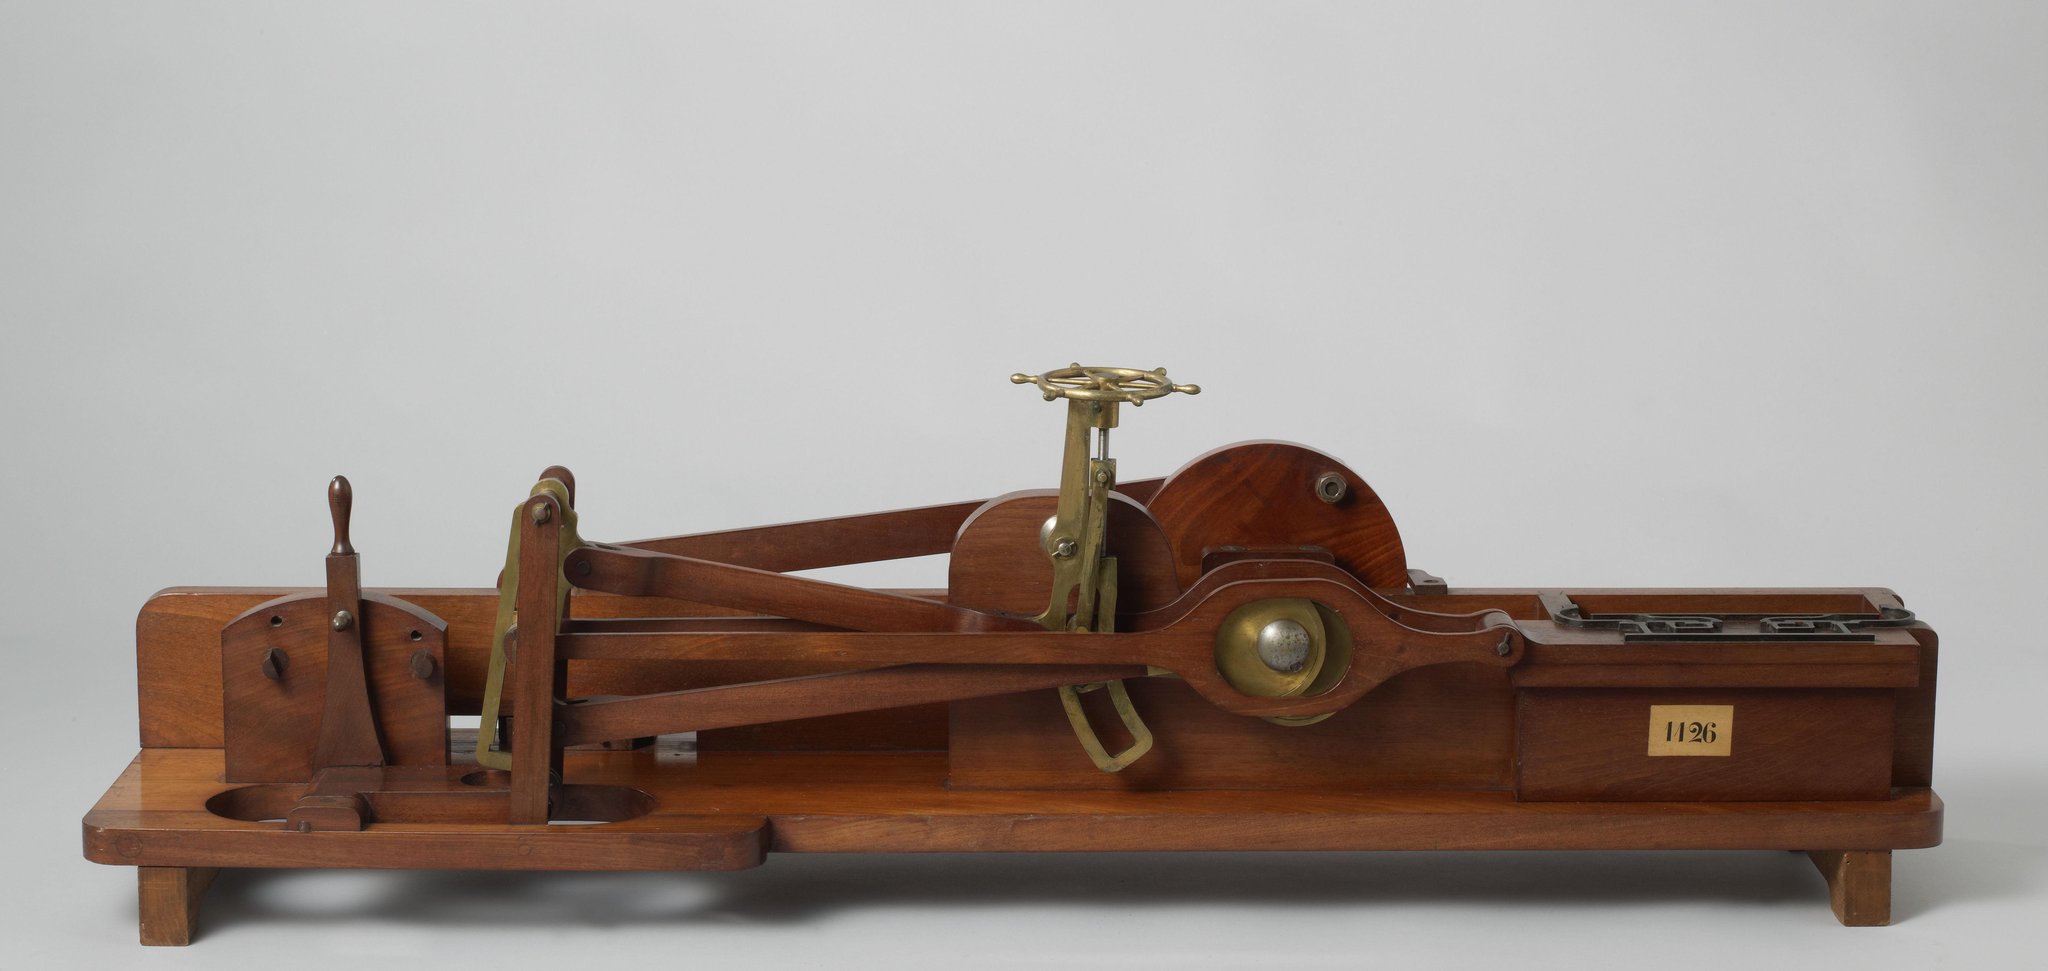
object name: demonstration model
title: Model Demonstrating the Movement of a Steam Valve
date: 1862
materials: brass, iron, wood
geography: delfshaven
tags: schouwen (schip)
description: Bewegend demonstratiemodel van een expansietoestel. De stoomschuif met vijf kamers wordt aangedreven en geregeld door een schaarbeweging op de krukas; de ene excentriek van de schaarbeweging kan in drie verschillende standen worden gezet, de andere kan met een wiel geregeld worden. De krukas wordt met een zwengel bediend.